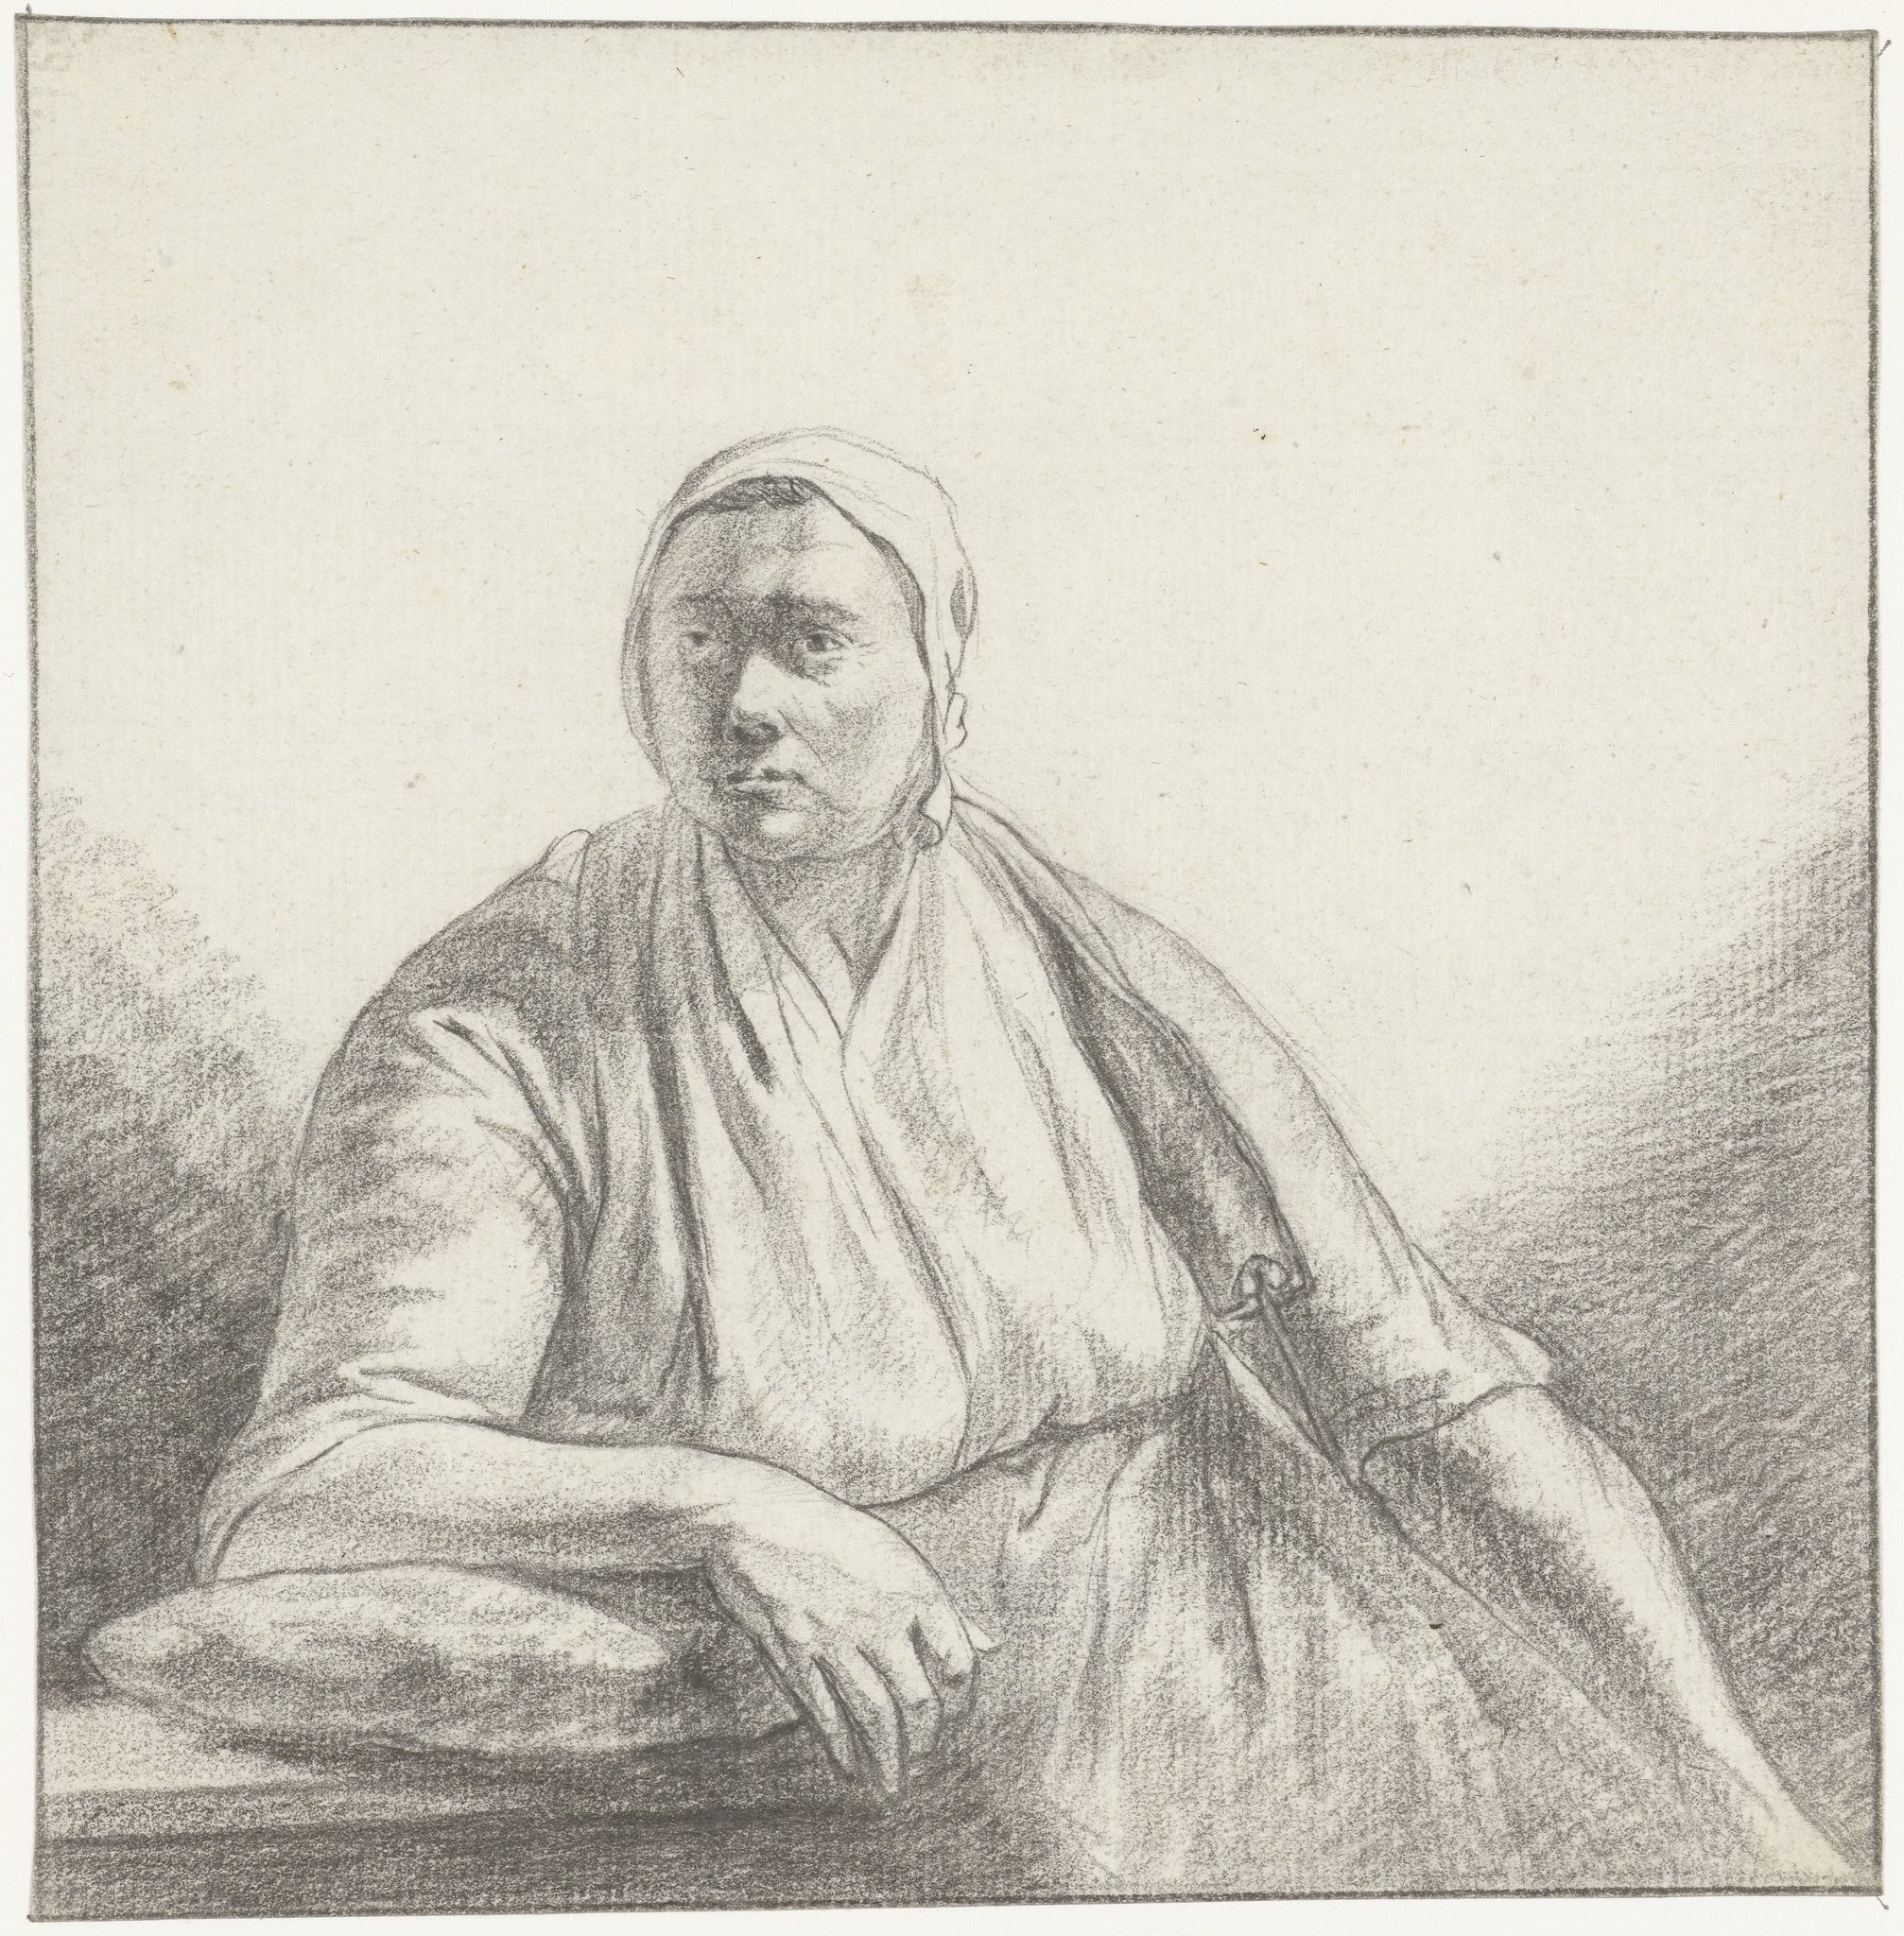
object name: drawing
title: Zittende vrouw, de rechterarm steunend op een kussen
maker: Anonymous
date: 1700-1800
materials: chalk, paper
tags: sitting figure